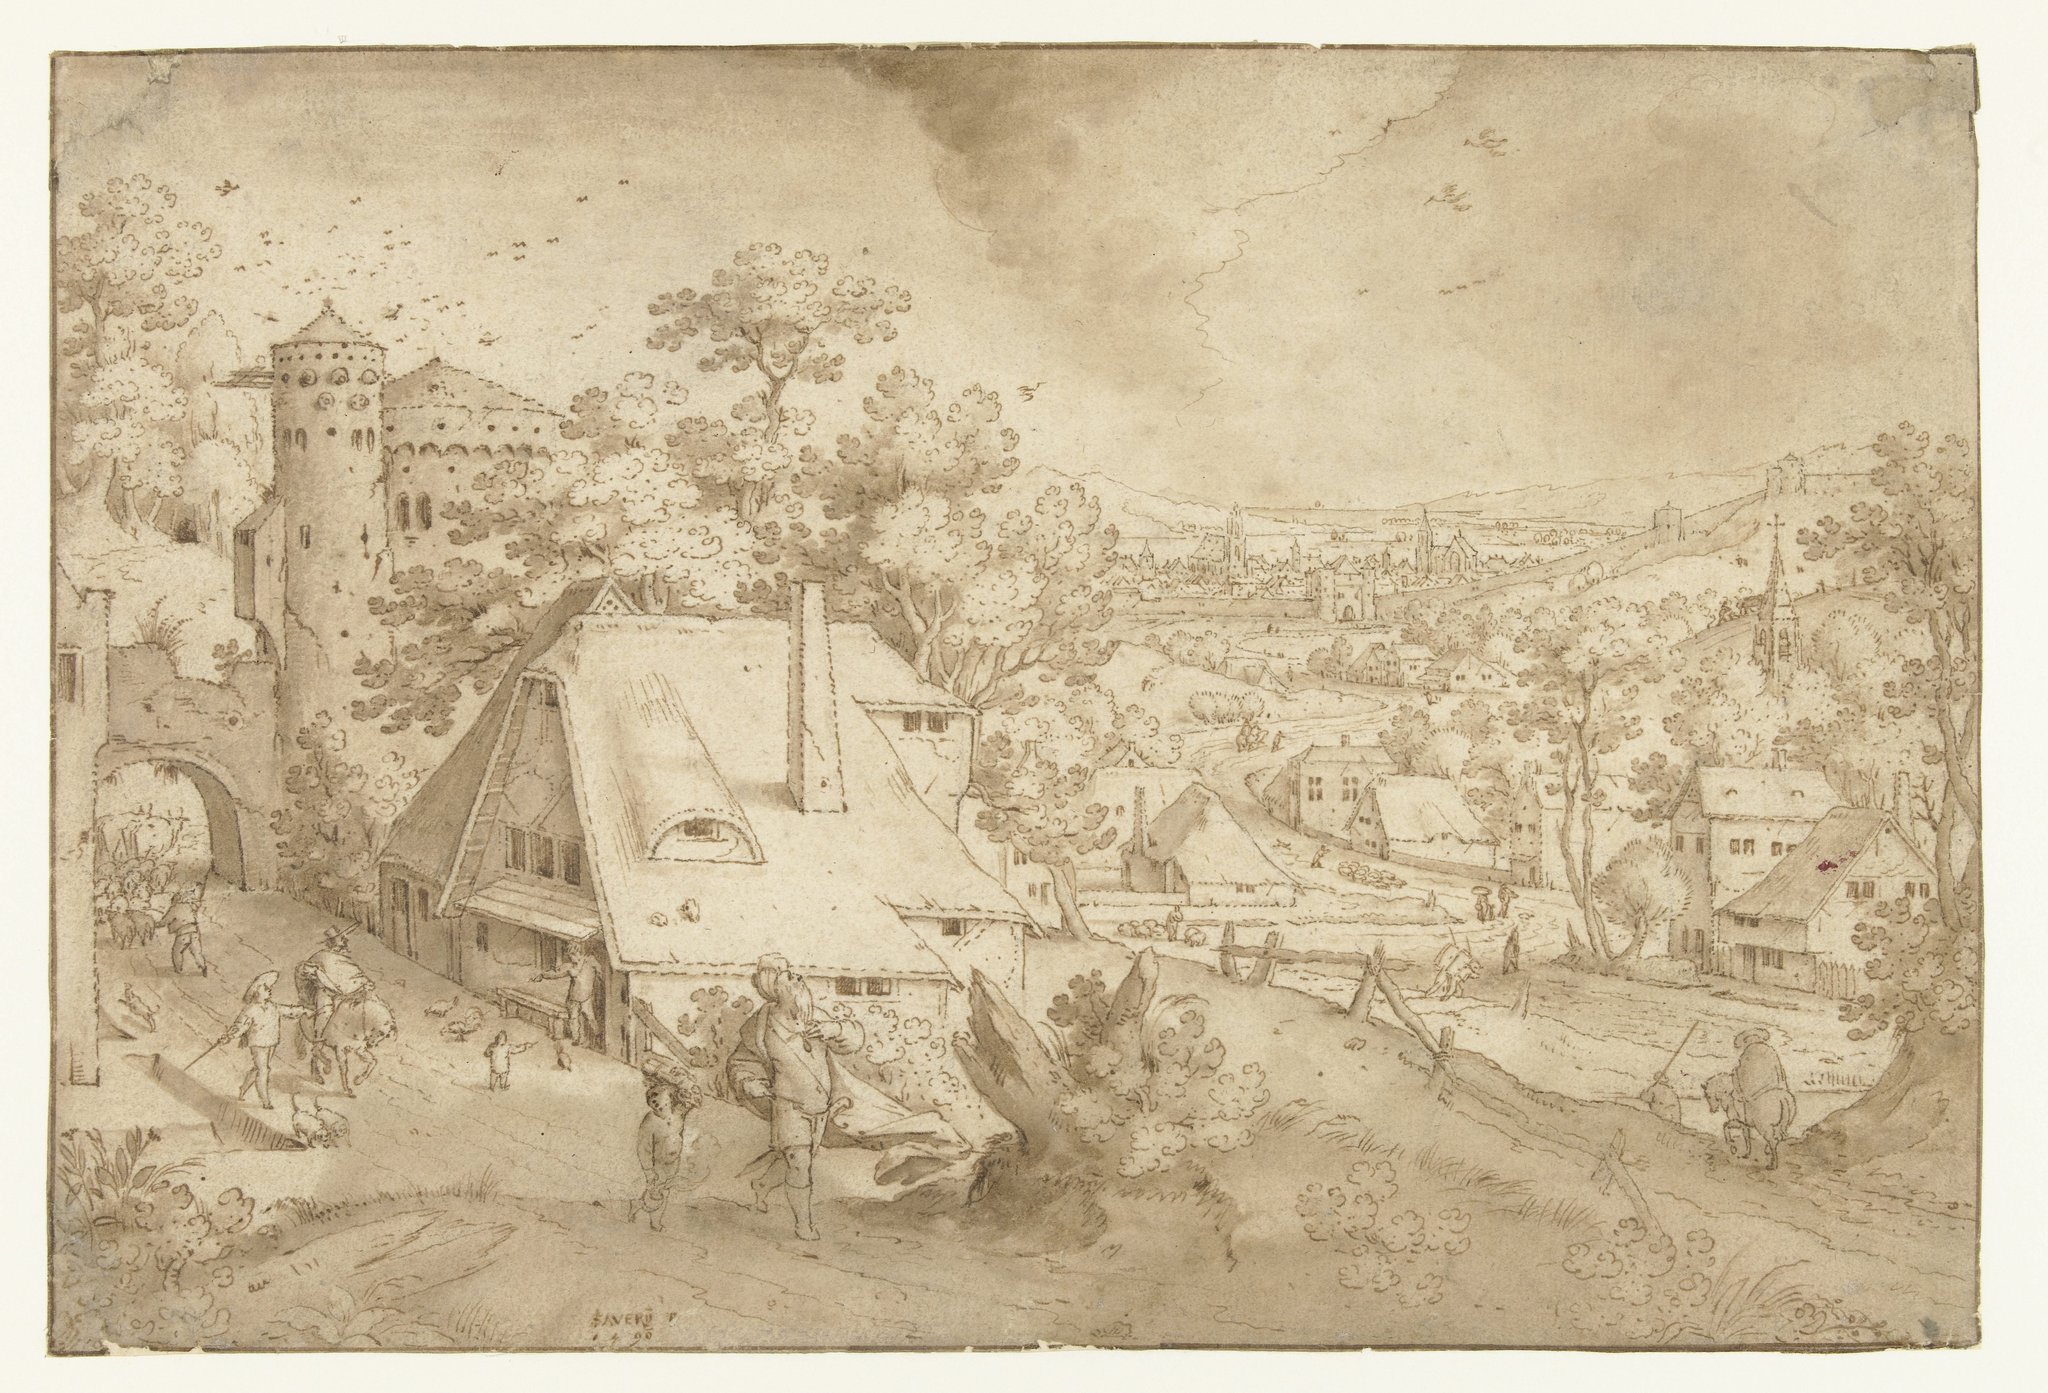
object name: drawing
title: Landschap met Abraham en Izaäk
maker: jacob savery (i)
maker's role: draughtsman, painter, print maker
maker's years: 1566-1603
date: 1590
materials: chalk, graphite, ink, paper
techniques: brush, pen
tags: abraham with isaac, an ass and the servants on their way to moriah, public road (+ city(-scape) with figures, staffage)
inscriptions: date